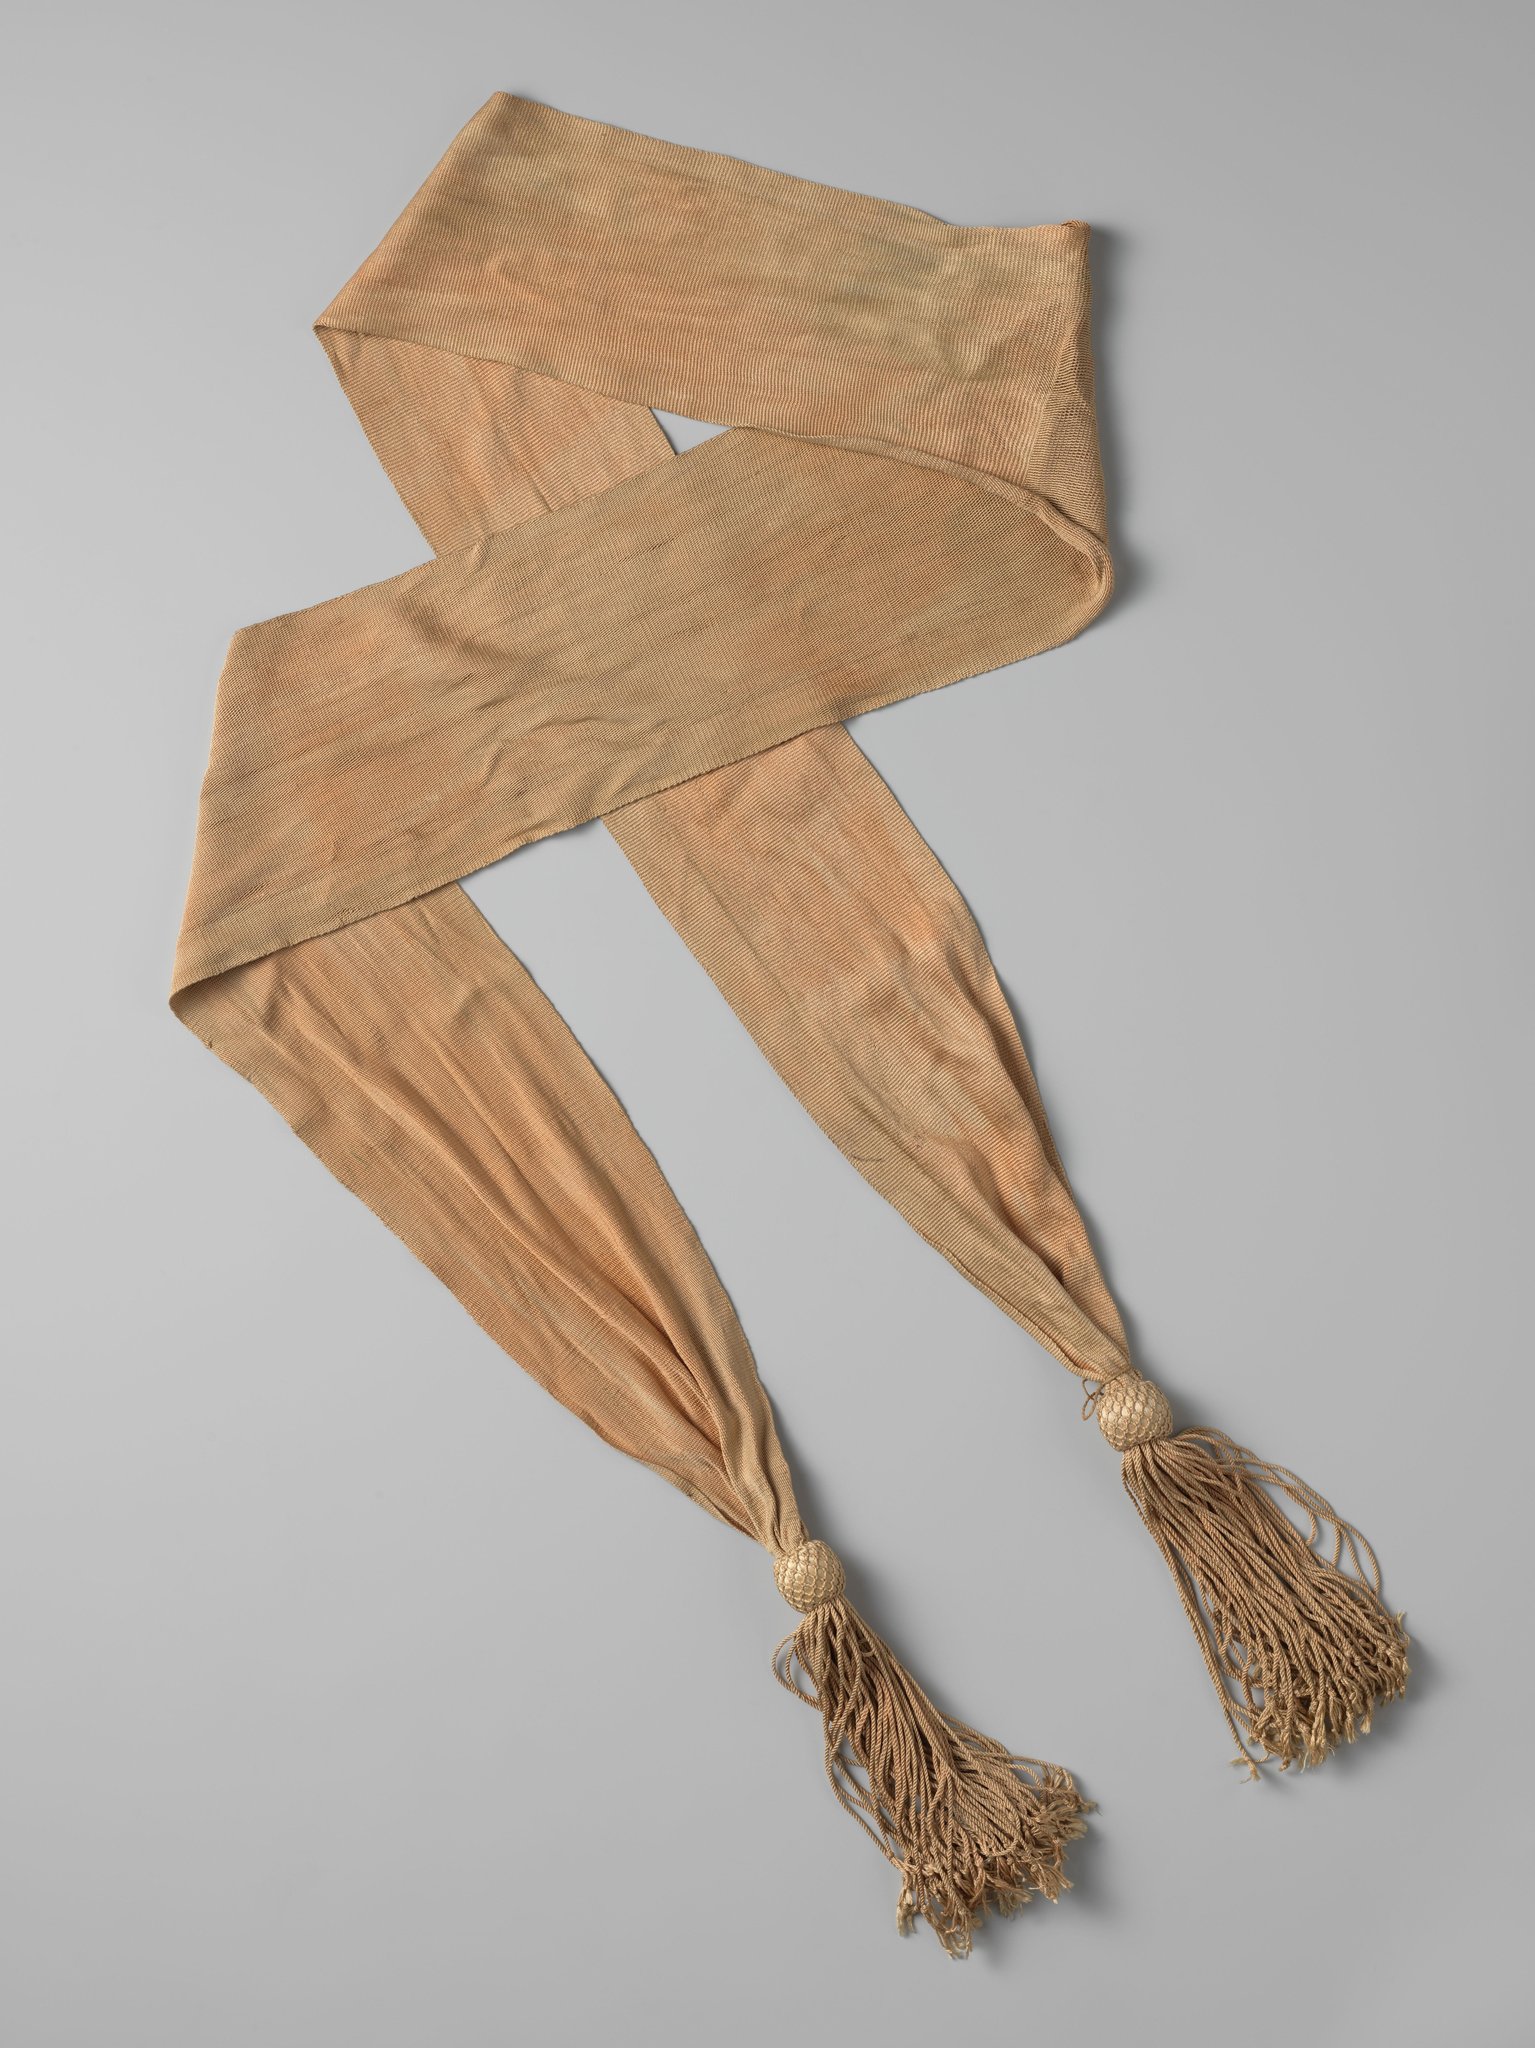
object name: sash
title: Sjerp M. 1815 voor officieren Nederlandse leger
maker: Anonymous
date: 1815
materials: silk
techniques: braiding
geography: netherlands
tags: david hendrik baron chassé, netherlands, belgium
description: Sjerp van oranje koordzijde, in techniek van Egyptisch vlechtwerk. Beide uiteinden eindigend in een bal, omgeven met een netwerk van dito stof. Uit de ballen ontspringen lange franjes. Elke franje heeft aan de onderzijde een knoop. Aan één zijde is een leren label met nr. 4 geknoopt. Gedragen door generaal baron Chassé, de verdediger van de citadel van Antwerpen (1832). Aangehechte lakzegel met familiewapen van Chassé.